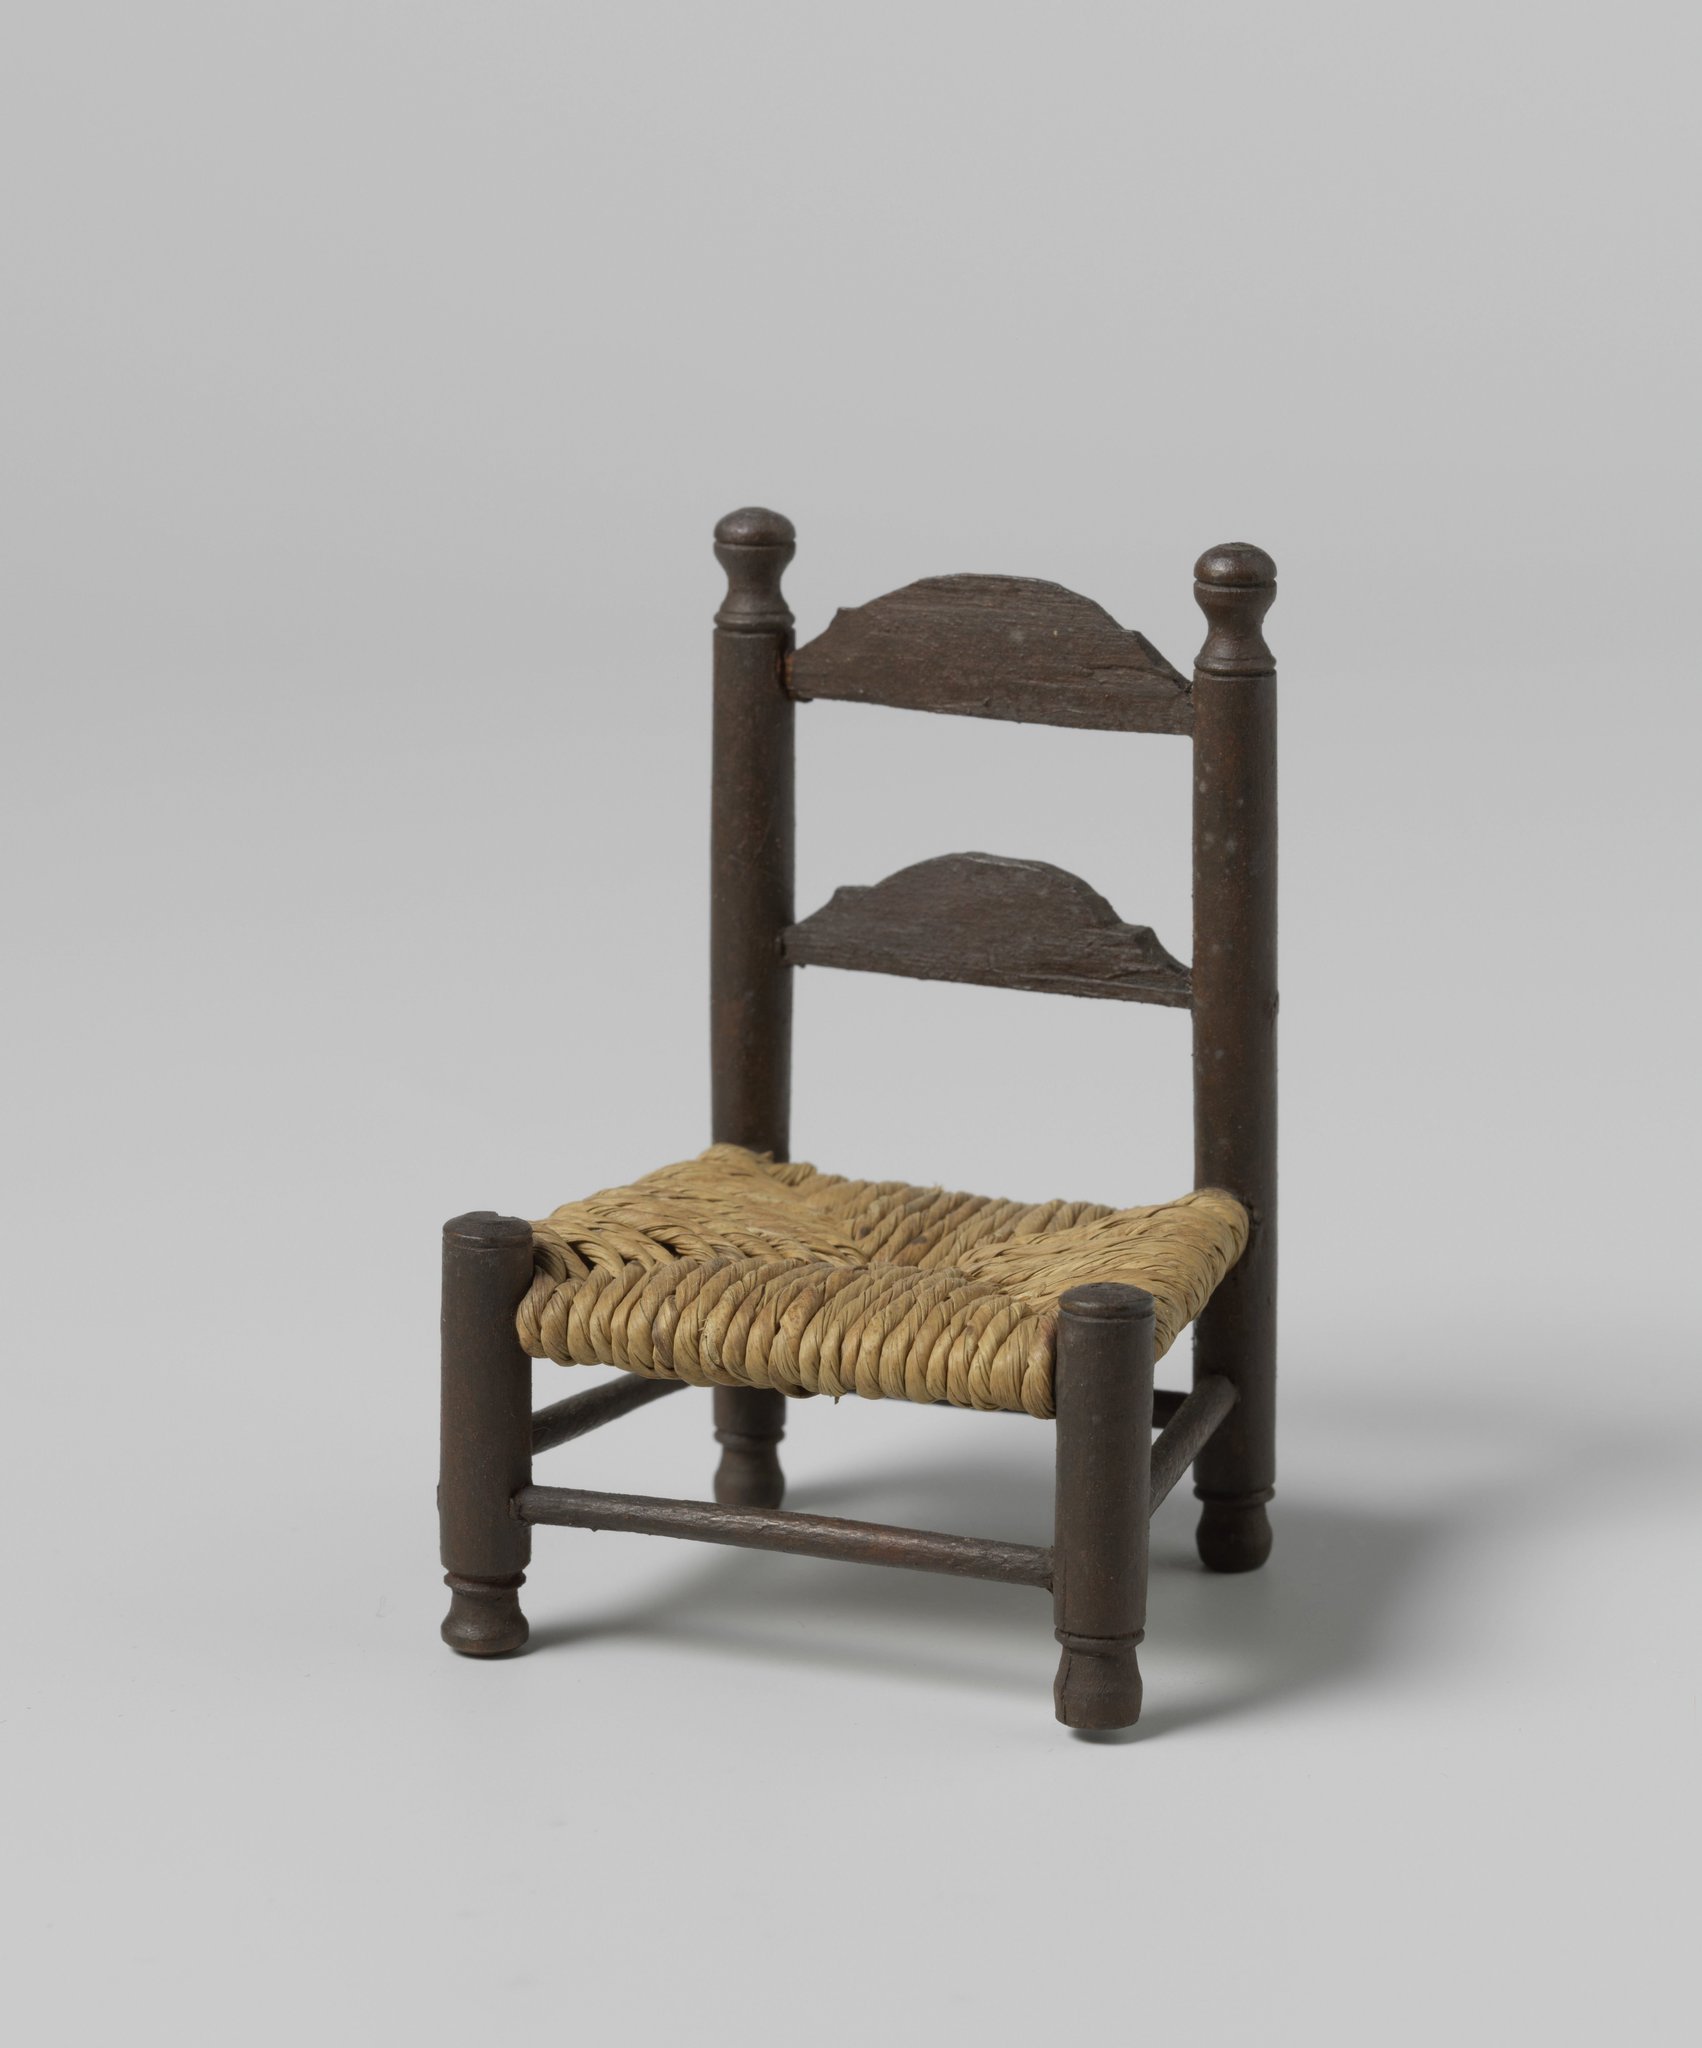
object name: knopstoel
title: Knopstoel, de rugleuning met twee dwarsregels, de zitting van gevlochten biezen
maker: Anonymous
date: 1750-1760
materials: fiber, wood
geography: amsterdam